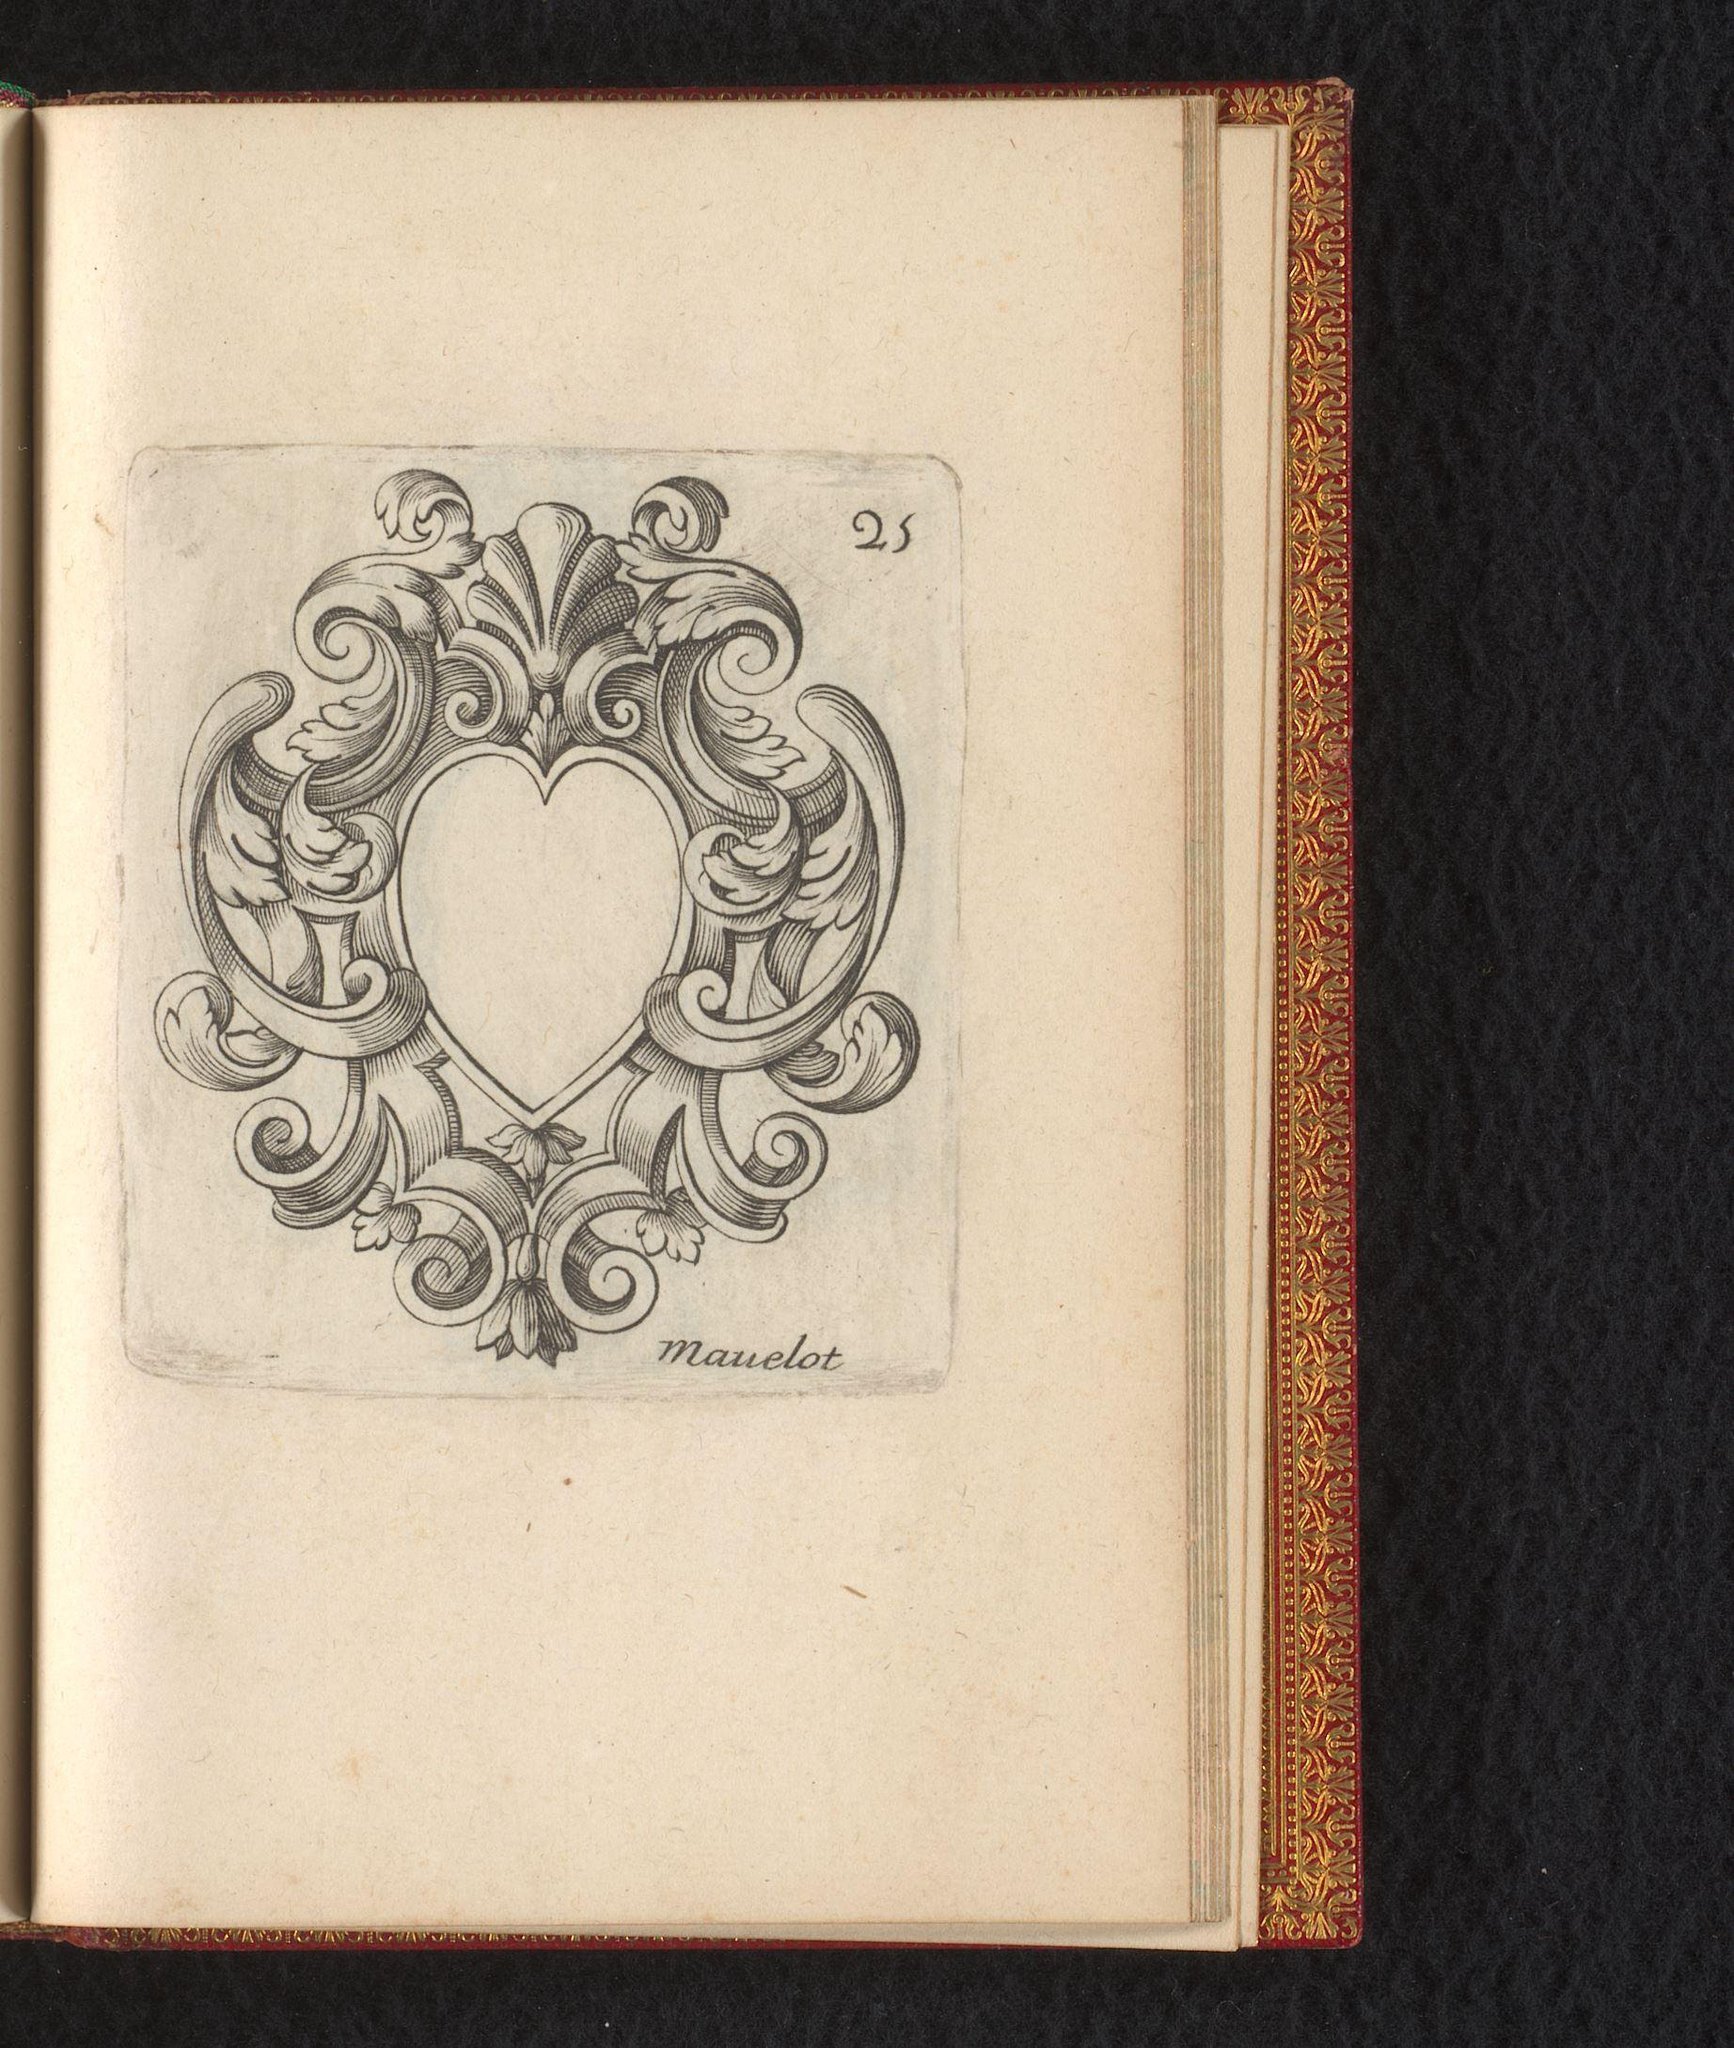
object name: album leaf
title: Hartvormige cartouche met rolwerk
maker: charles mavelot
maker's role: draughtsman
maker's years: 1680-1742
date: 1685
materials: paper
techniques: engraving, etching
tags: heart symbolism, scrollwork, strapwork ~ ornament, ornament ~ other curved forms, ornament ~ cartouche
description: Rechtsboven genummerd: 25. Prent maakt deel uit van een album.